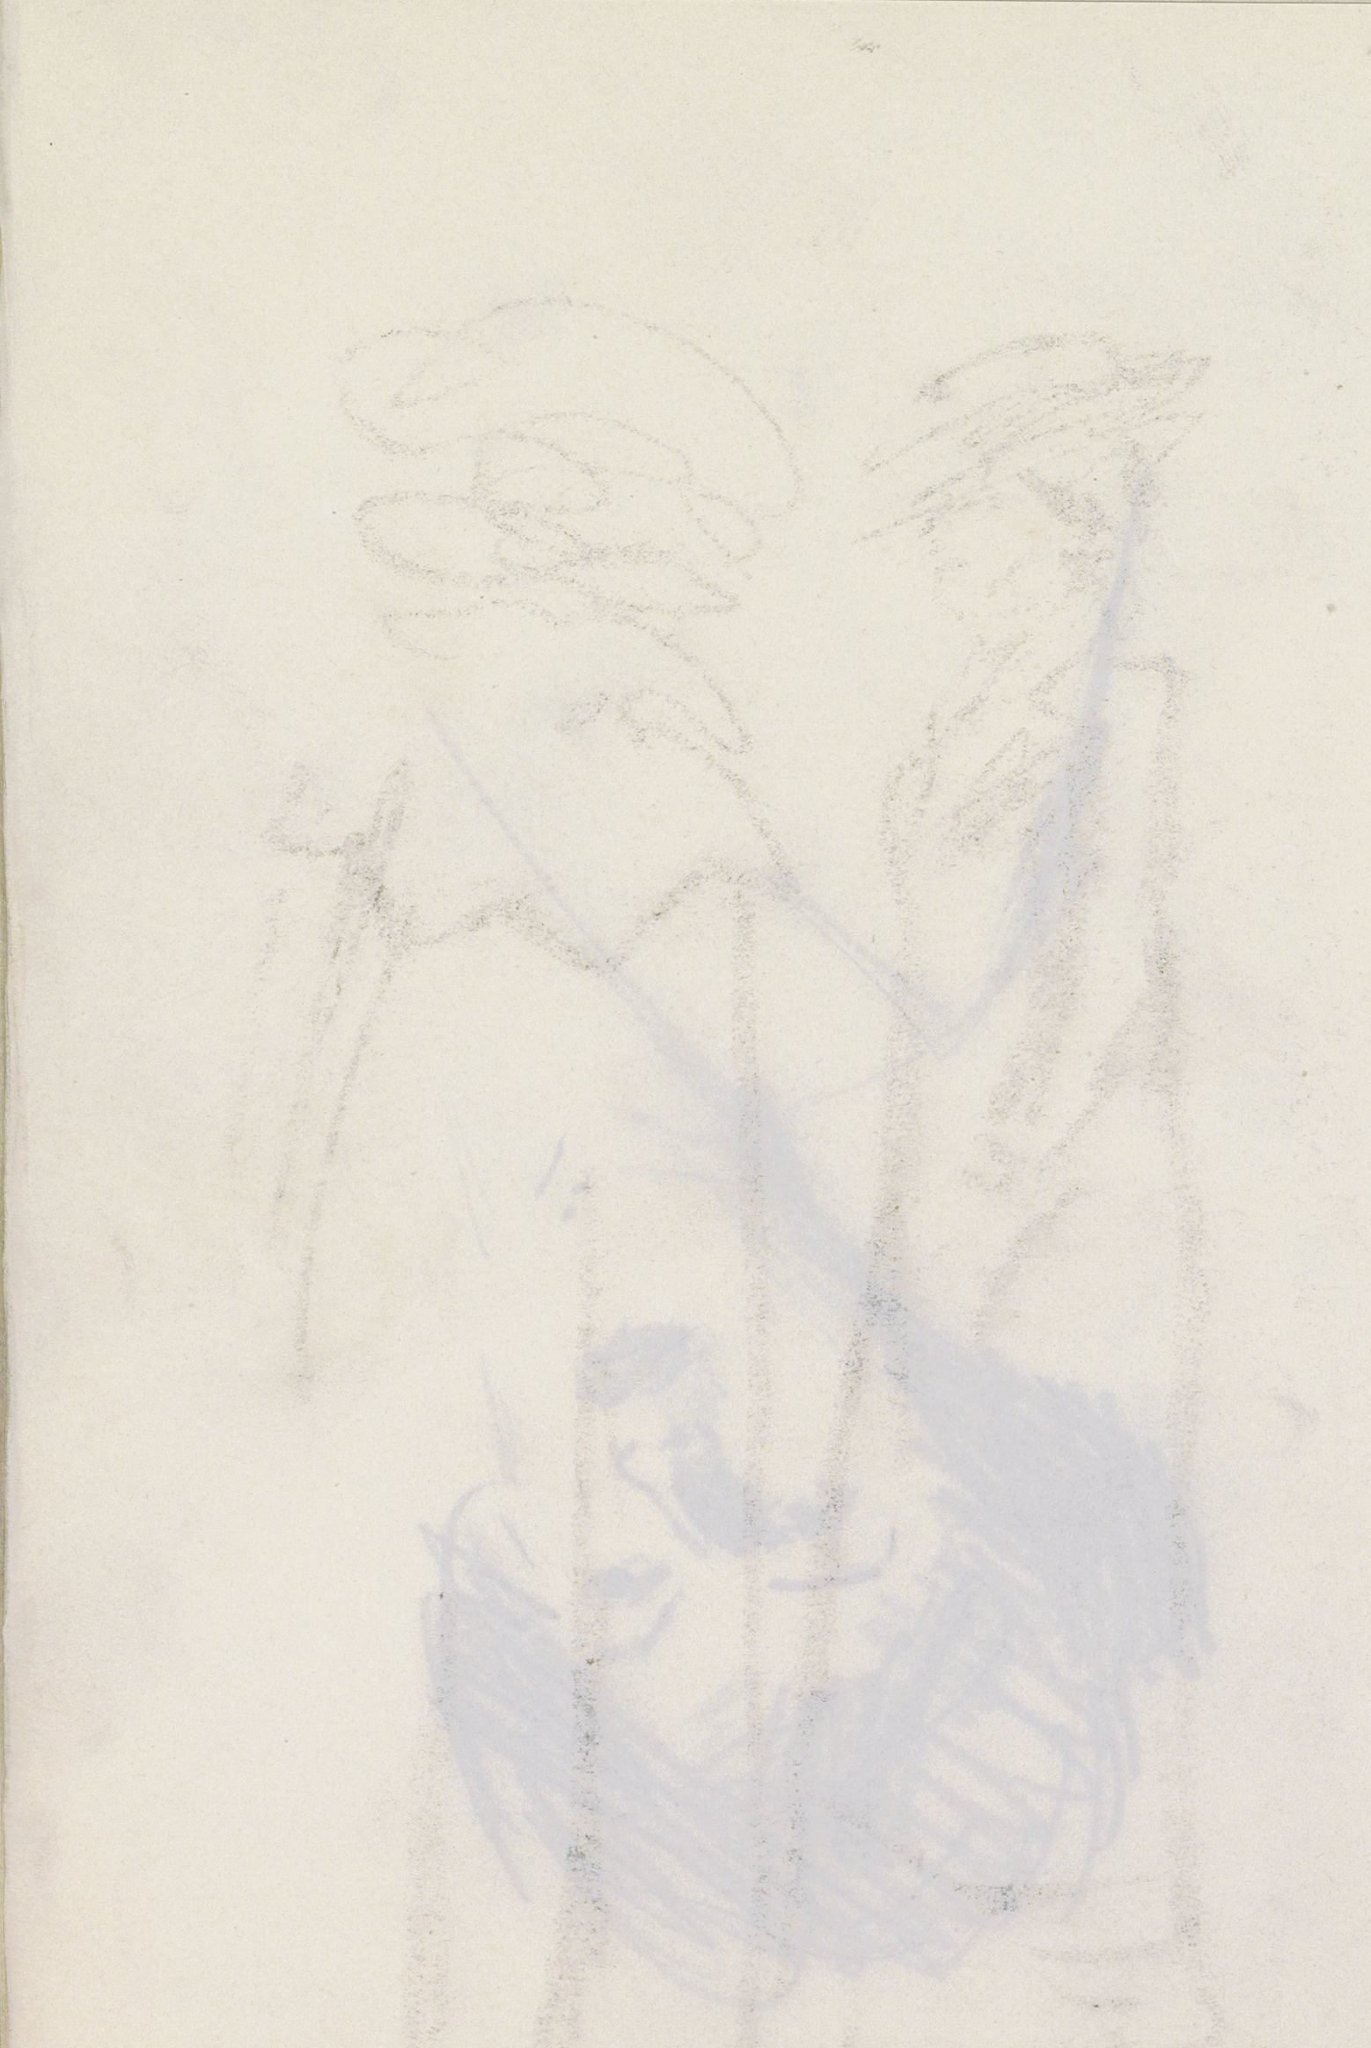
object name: sketchbook leaf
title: Abklatsch van de krijttekening op blad 20 recto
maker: isaac israels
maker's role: draughtsman, painter, print maker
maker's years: 1865-1934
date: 1875-1934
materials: paper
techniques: printmaking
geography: paris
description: Blad 19 verso uit schetsboek L met 42 bladen.